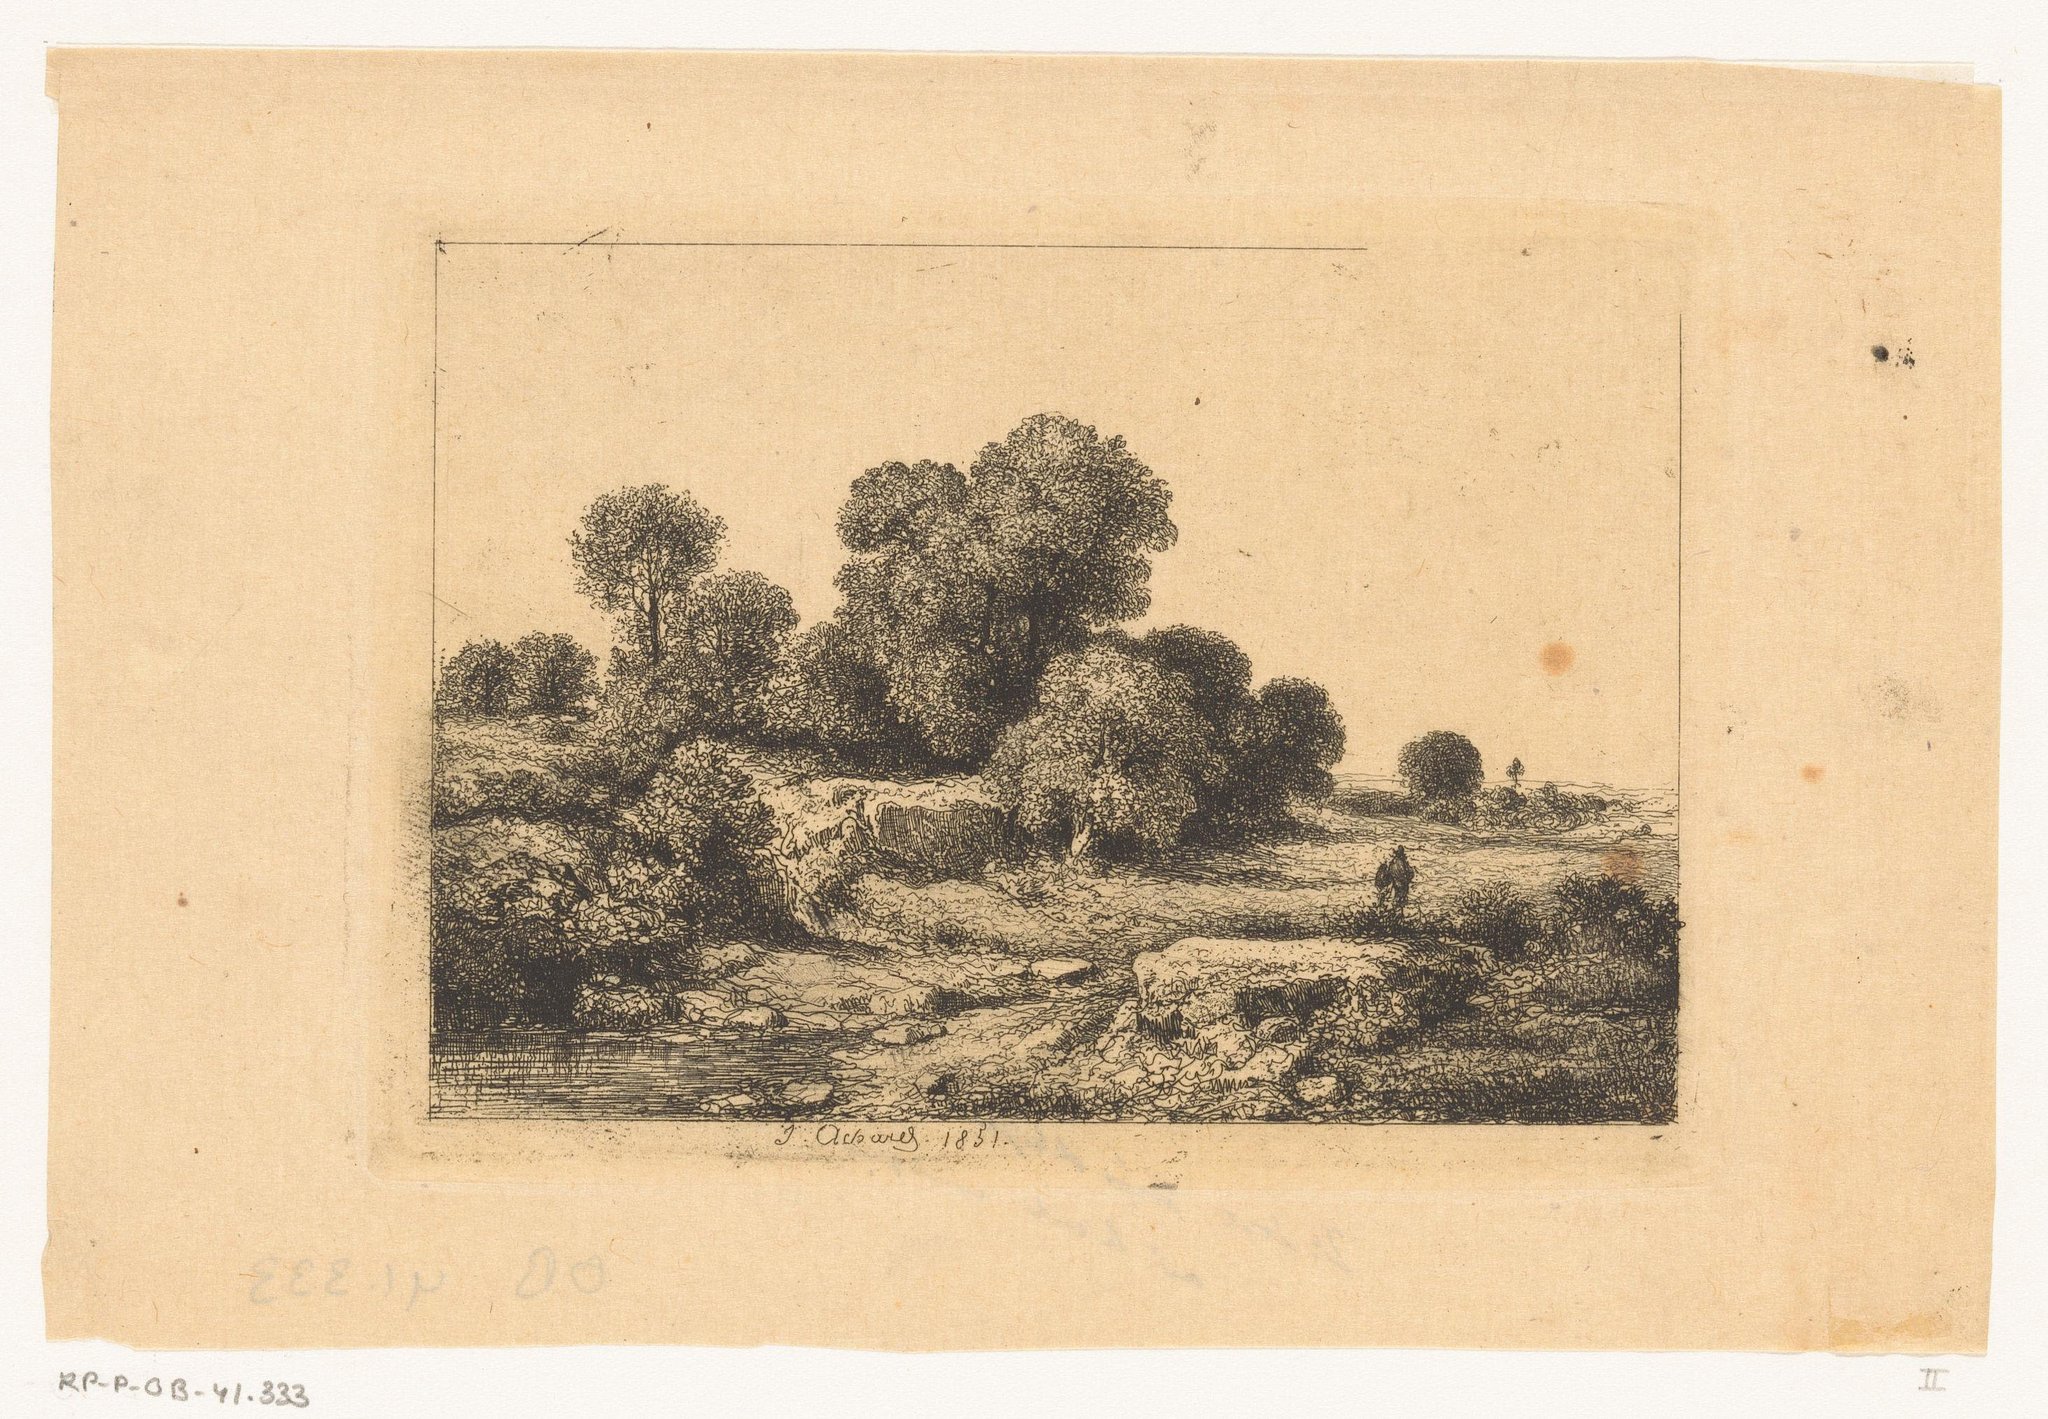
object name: print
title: Figuren bij een rivierbedding met bomen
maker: jean alexis achard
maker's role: print maker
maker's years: 1807-1884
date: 1851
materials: paper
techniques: etching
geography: france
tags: trees, dry river, river bed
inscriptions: inscription: ‘2me état / epr. d'essai / avant [...] unique’, collector's mark: Lugt 2228